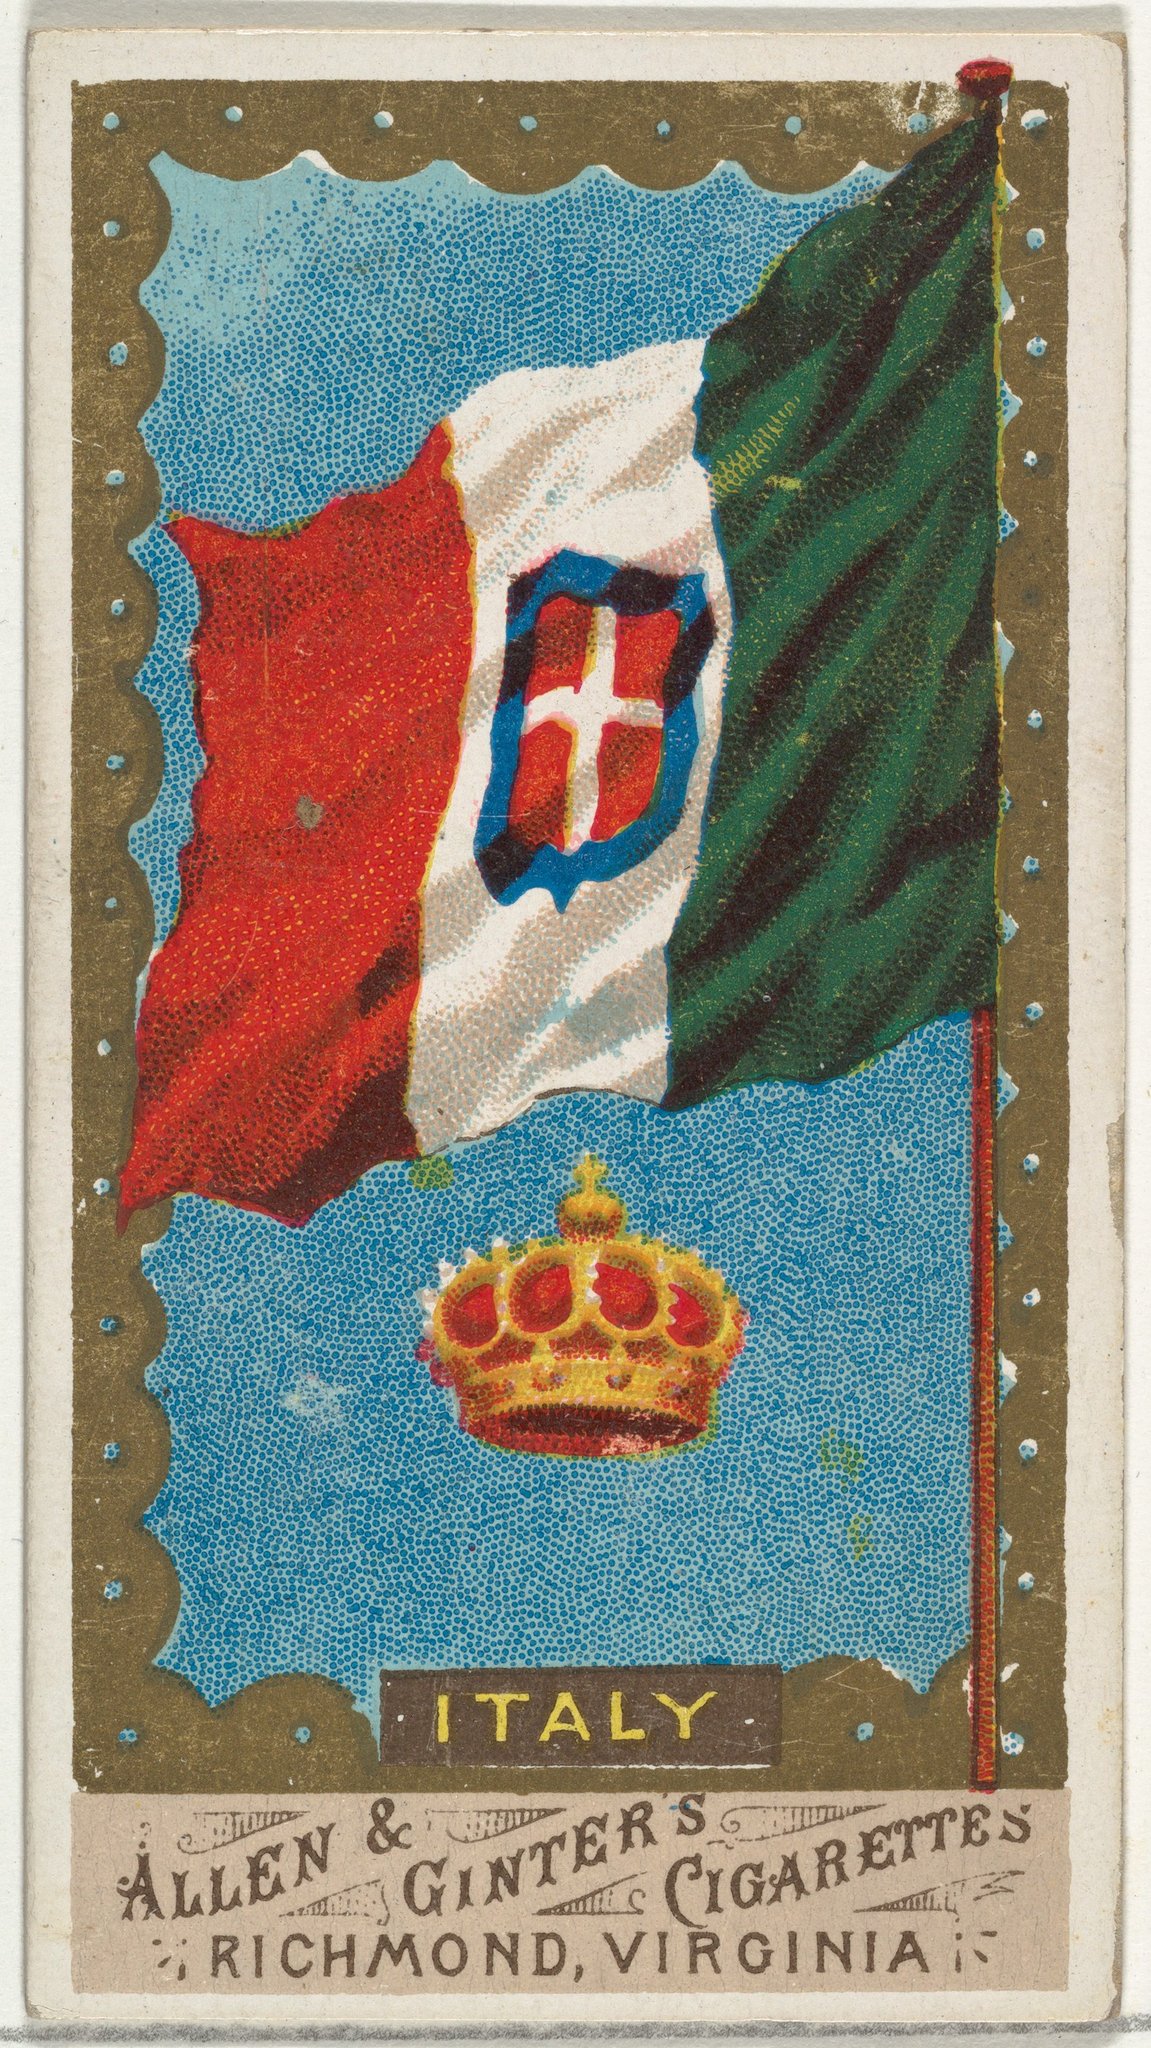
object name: print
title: Italy, from Flags of All Nations, Series 1 (N9) for Allen & Ginter Cigarettes Brands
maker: allen & ginter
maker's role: publisher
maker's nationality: american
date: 1887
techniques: color lithograph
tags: coat of arms,flags